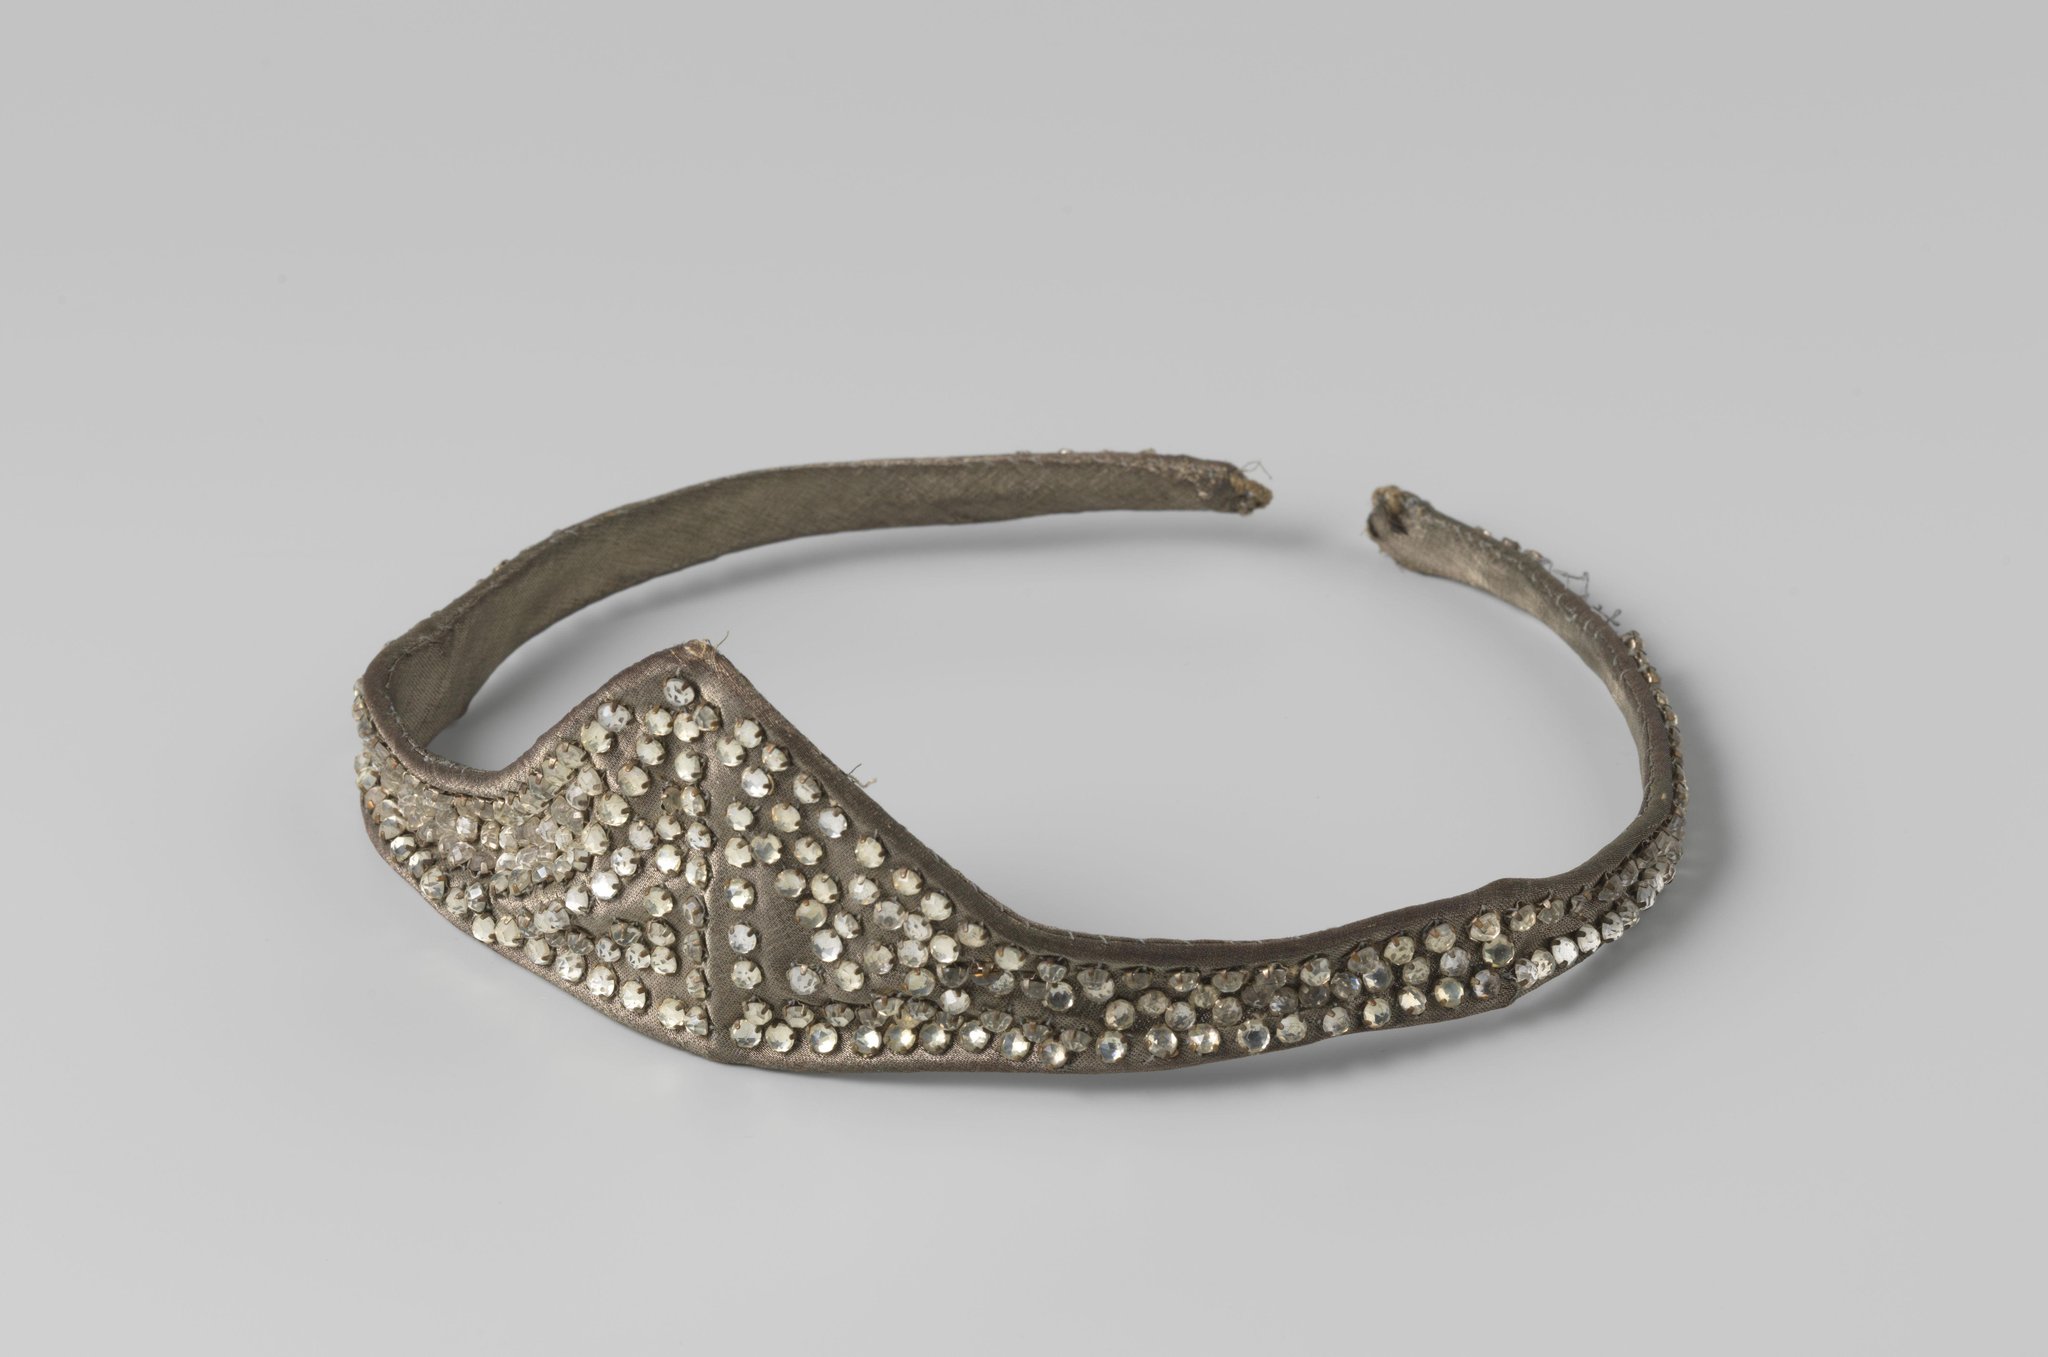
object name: diadem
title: Diadeem of ceintuur van zilverbrokaat met stras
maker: Anonymous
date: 1910-1920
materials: paste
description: Diadeem of ceintuur van zilverbrokaat en stras. Toneel rekwisiet ? Verstevigde beugel met driehoekig opstaand middenstuk. Door de trensjes kan zowel een korte als een lange band gehaald worden voor bevestiging, kan dus voor de omvang van hoofd of middel gediend hebben. Oorspronkelijk gedragen bij de empire japon van witte batist met zilveren takjes en streepjes.